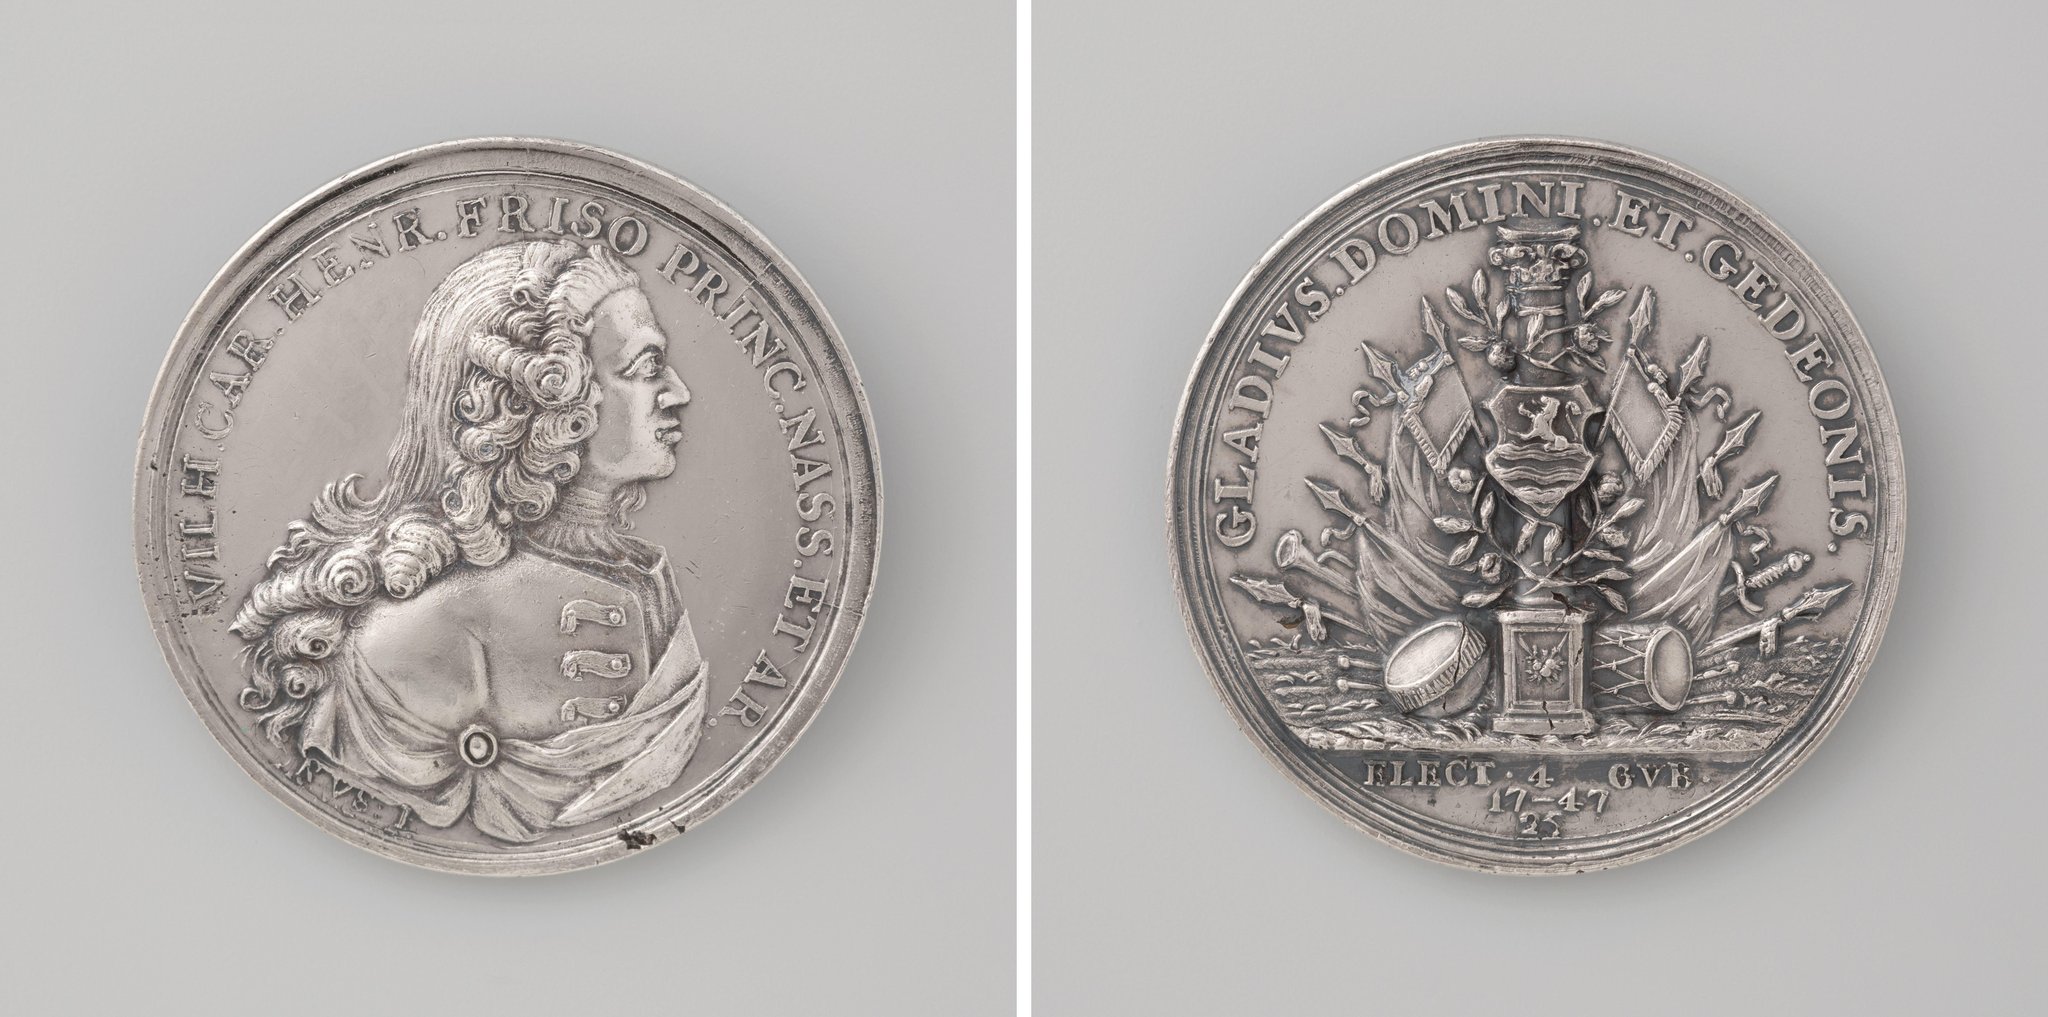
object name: history medal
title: Verheffing van de prins van Oranje tot stadhouder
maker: nicolaas van swinderen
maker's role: jeweler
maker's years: 1705-1760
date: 1747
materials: silver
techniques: striking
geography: the hague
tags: willem iv (prins van oranje-nassau)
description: Zilveren penning. Voorzijde: borststuk man binnen omschrift. Keerzijde: trophee, opgebouwd uit vaandels, wapentuig, trommen en een met oranjetakken omwonden zuil, waaraan wapenschild bevestigd is binnen omschrift; afsnede: opschrift